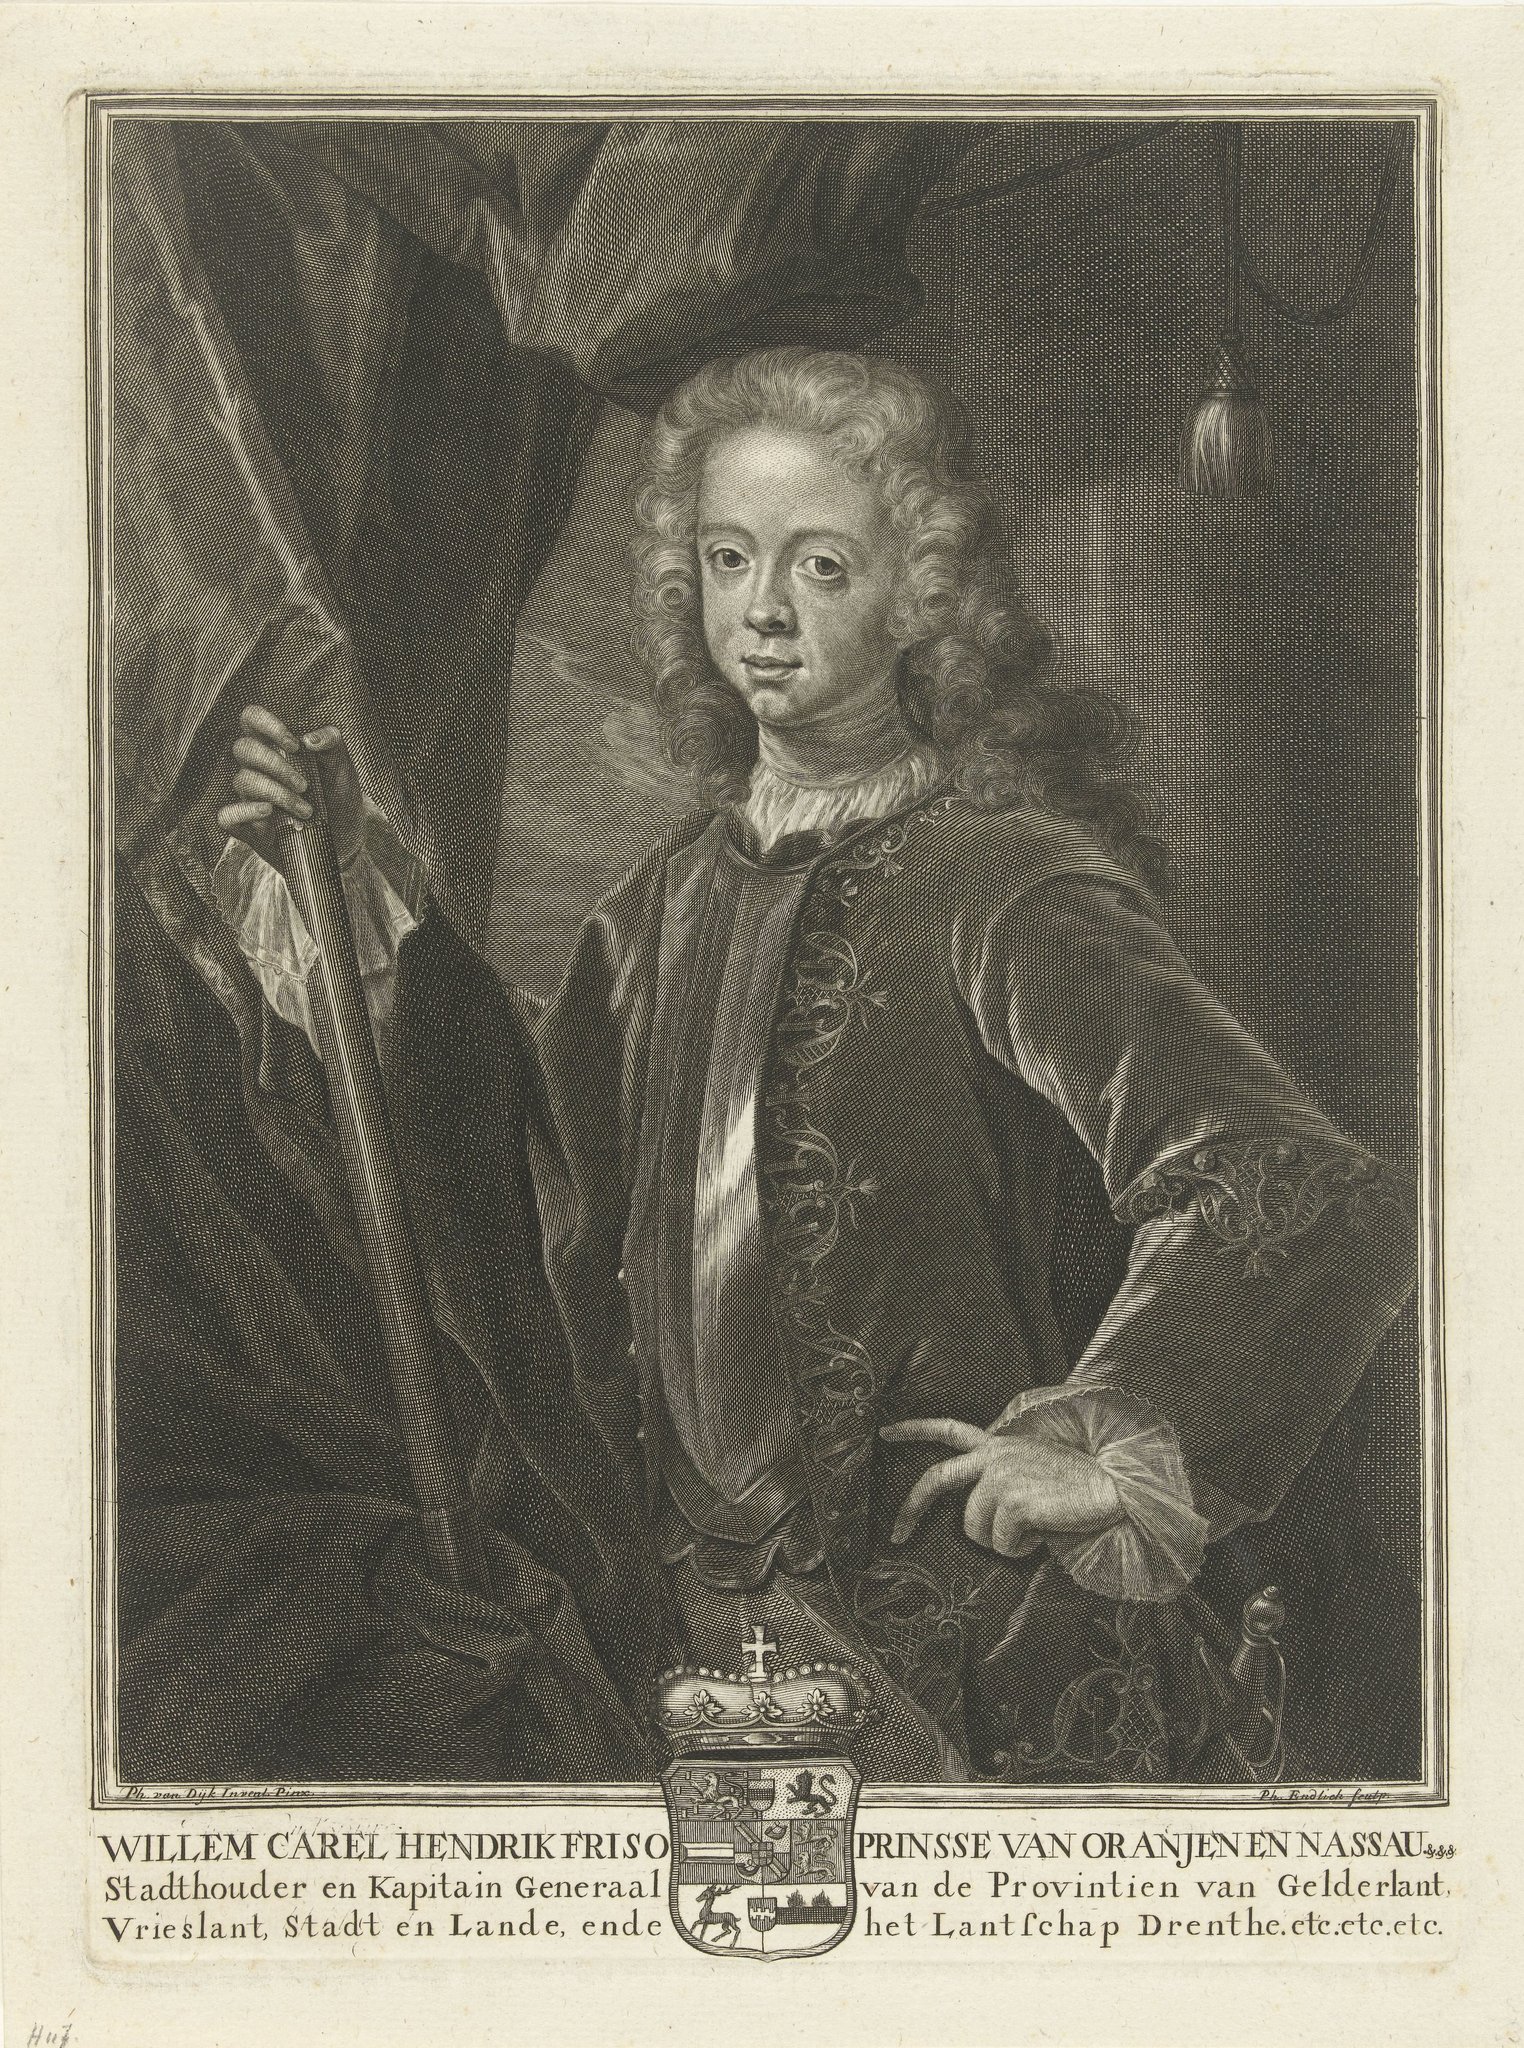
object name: print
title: Portret van Willem Karel Hendrik Friso van Oranje-Nassau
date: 1731-1748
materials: paper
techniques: engraving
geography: netherlands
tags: the hague, willem iv (prins van oranje-nassau)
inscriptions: collector's mark: Lugt 2760, collector's mark: Lugt 2228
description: Portret ten halven lijve van Willem Karel Hendrik Friso (Willem IV) van Oranje-Nassau. De prins is afgebeeld met de hand in de zij en een commandostaf in de andere hand. De omlijsting wordt onderbroken door het familiewapen met aan weerszijden drie regels tekst in het Nederlands.